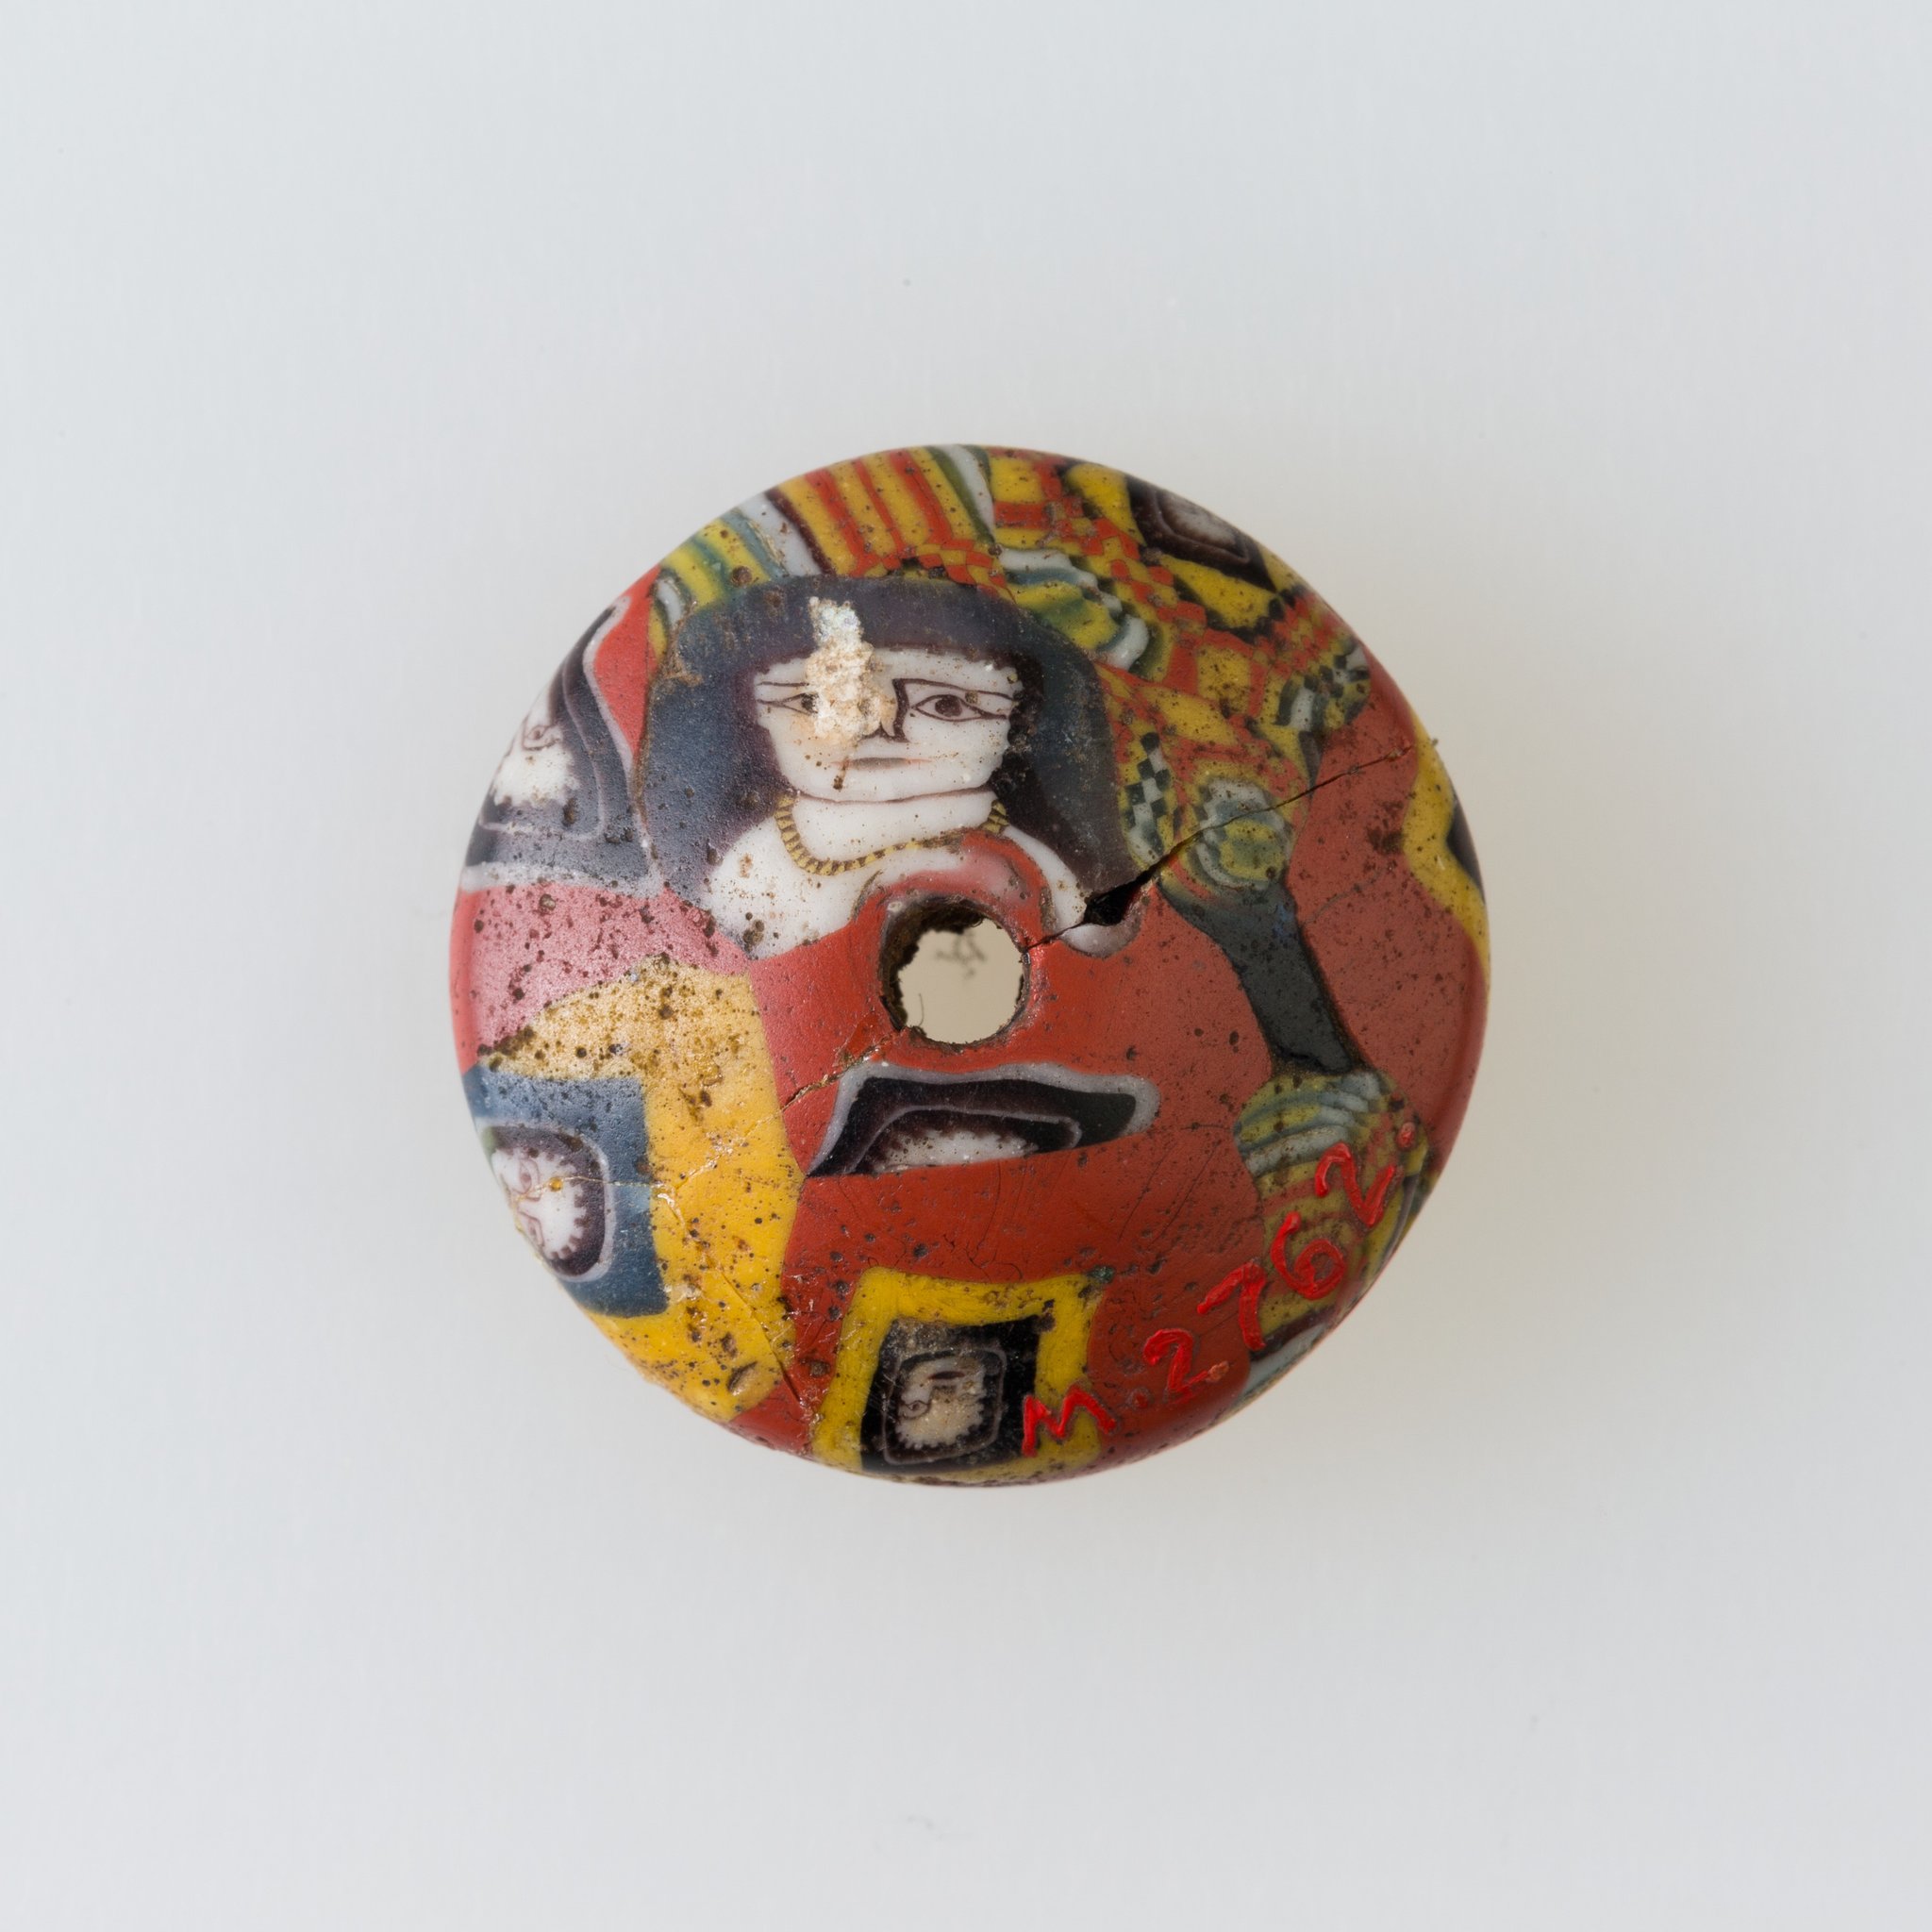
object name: inlay, circular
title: Bead with face canes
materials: glass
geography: egypt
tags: human figures,faces